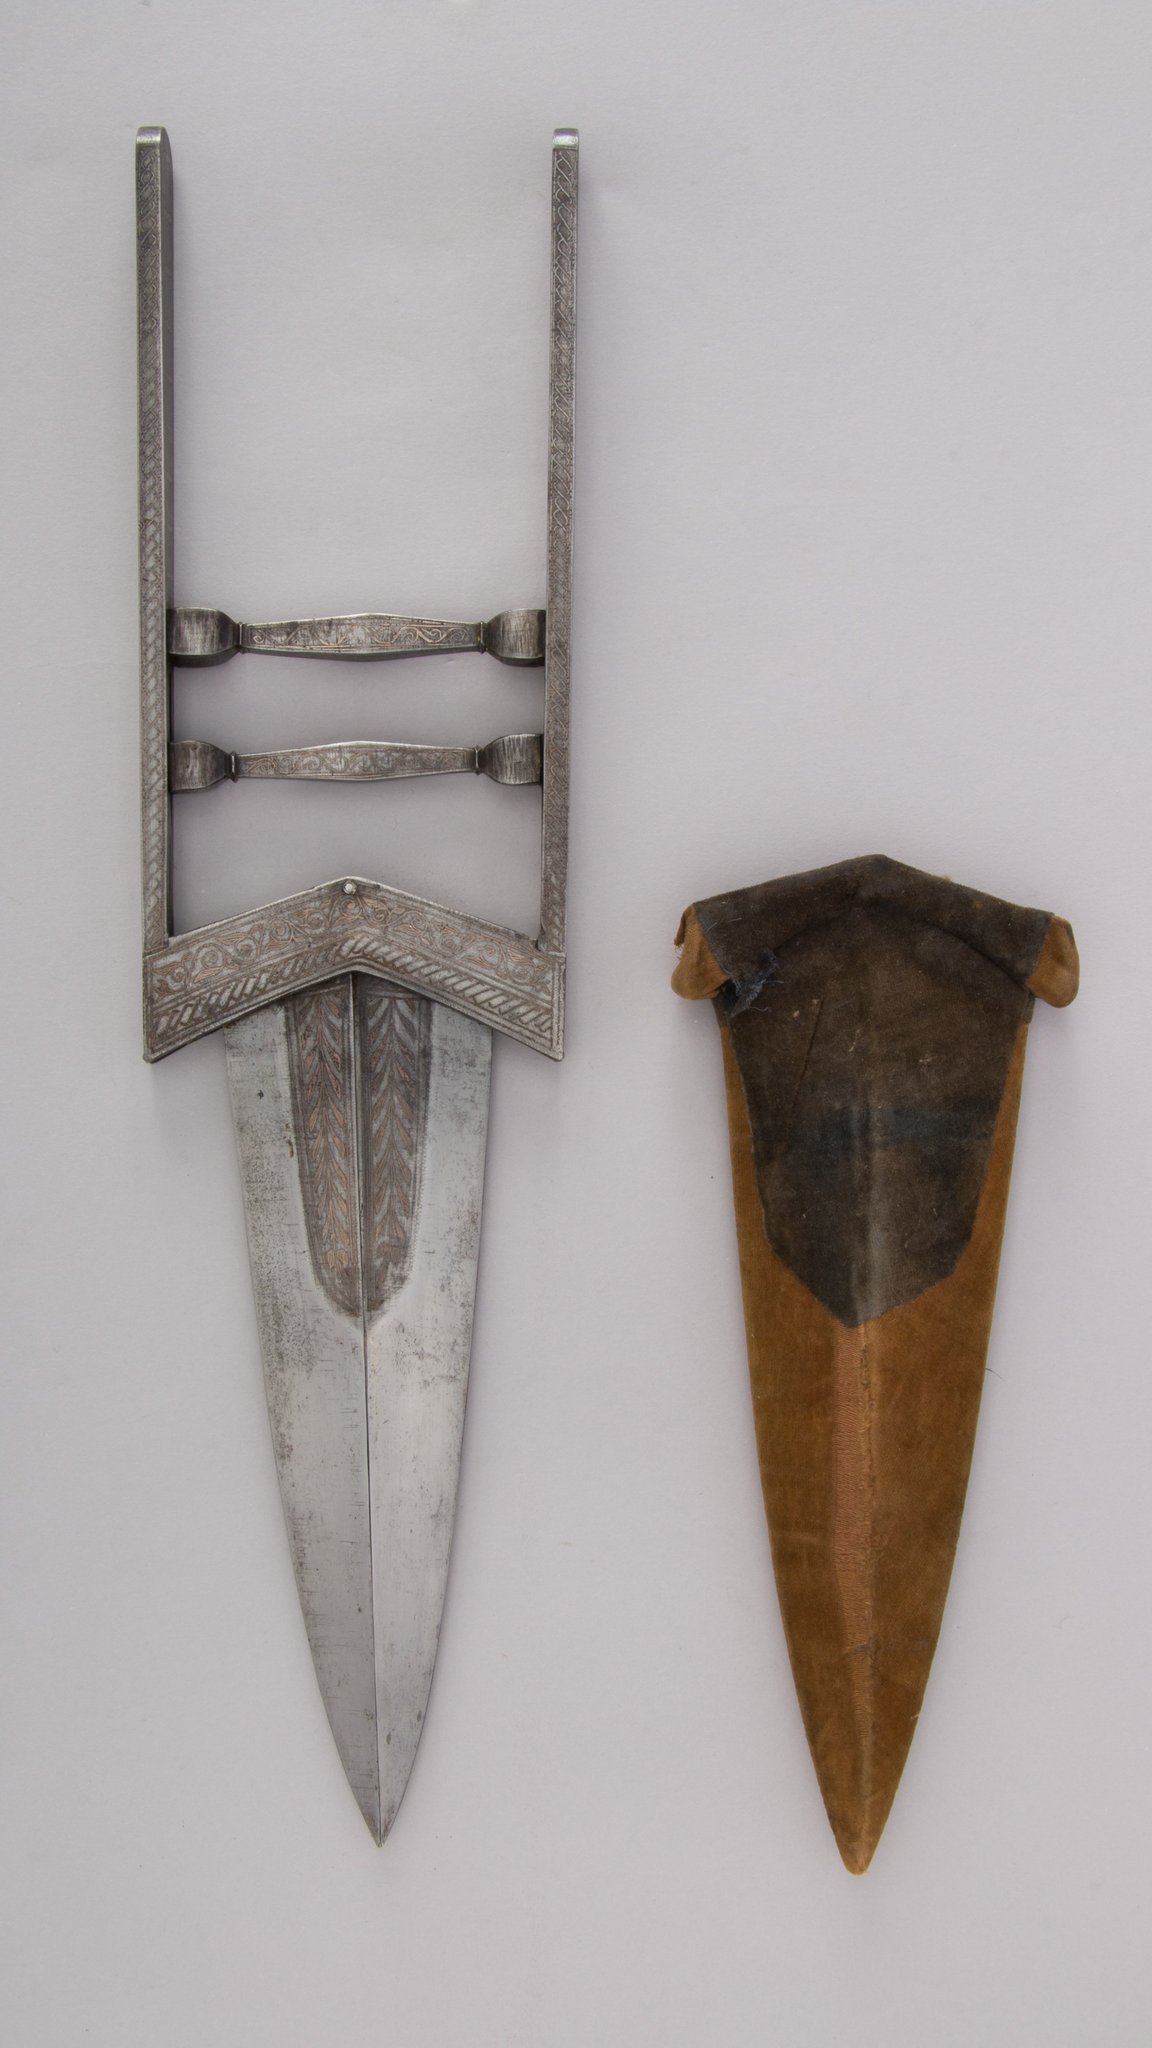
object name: dagger with sheath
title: Dagger (Katar) with Sheath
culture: indian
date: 1801-1900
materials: cotton, silver, steel, velvet, wood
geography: india